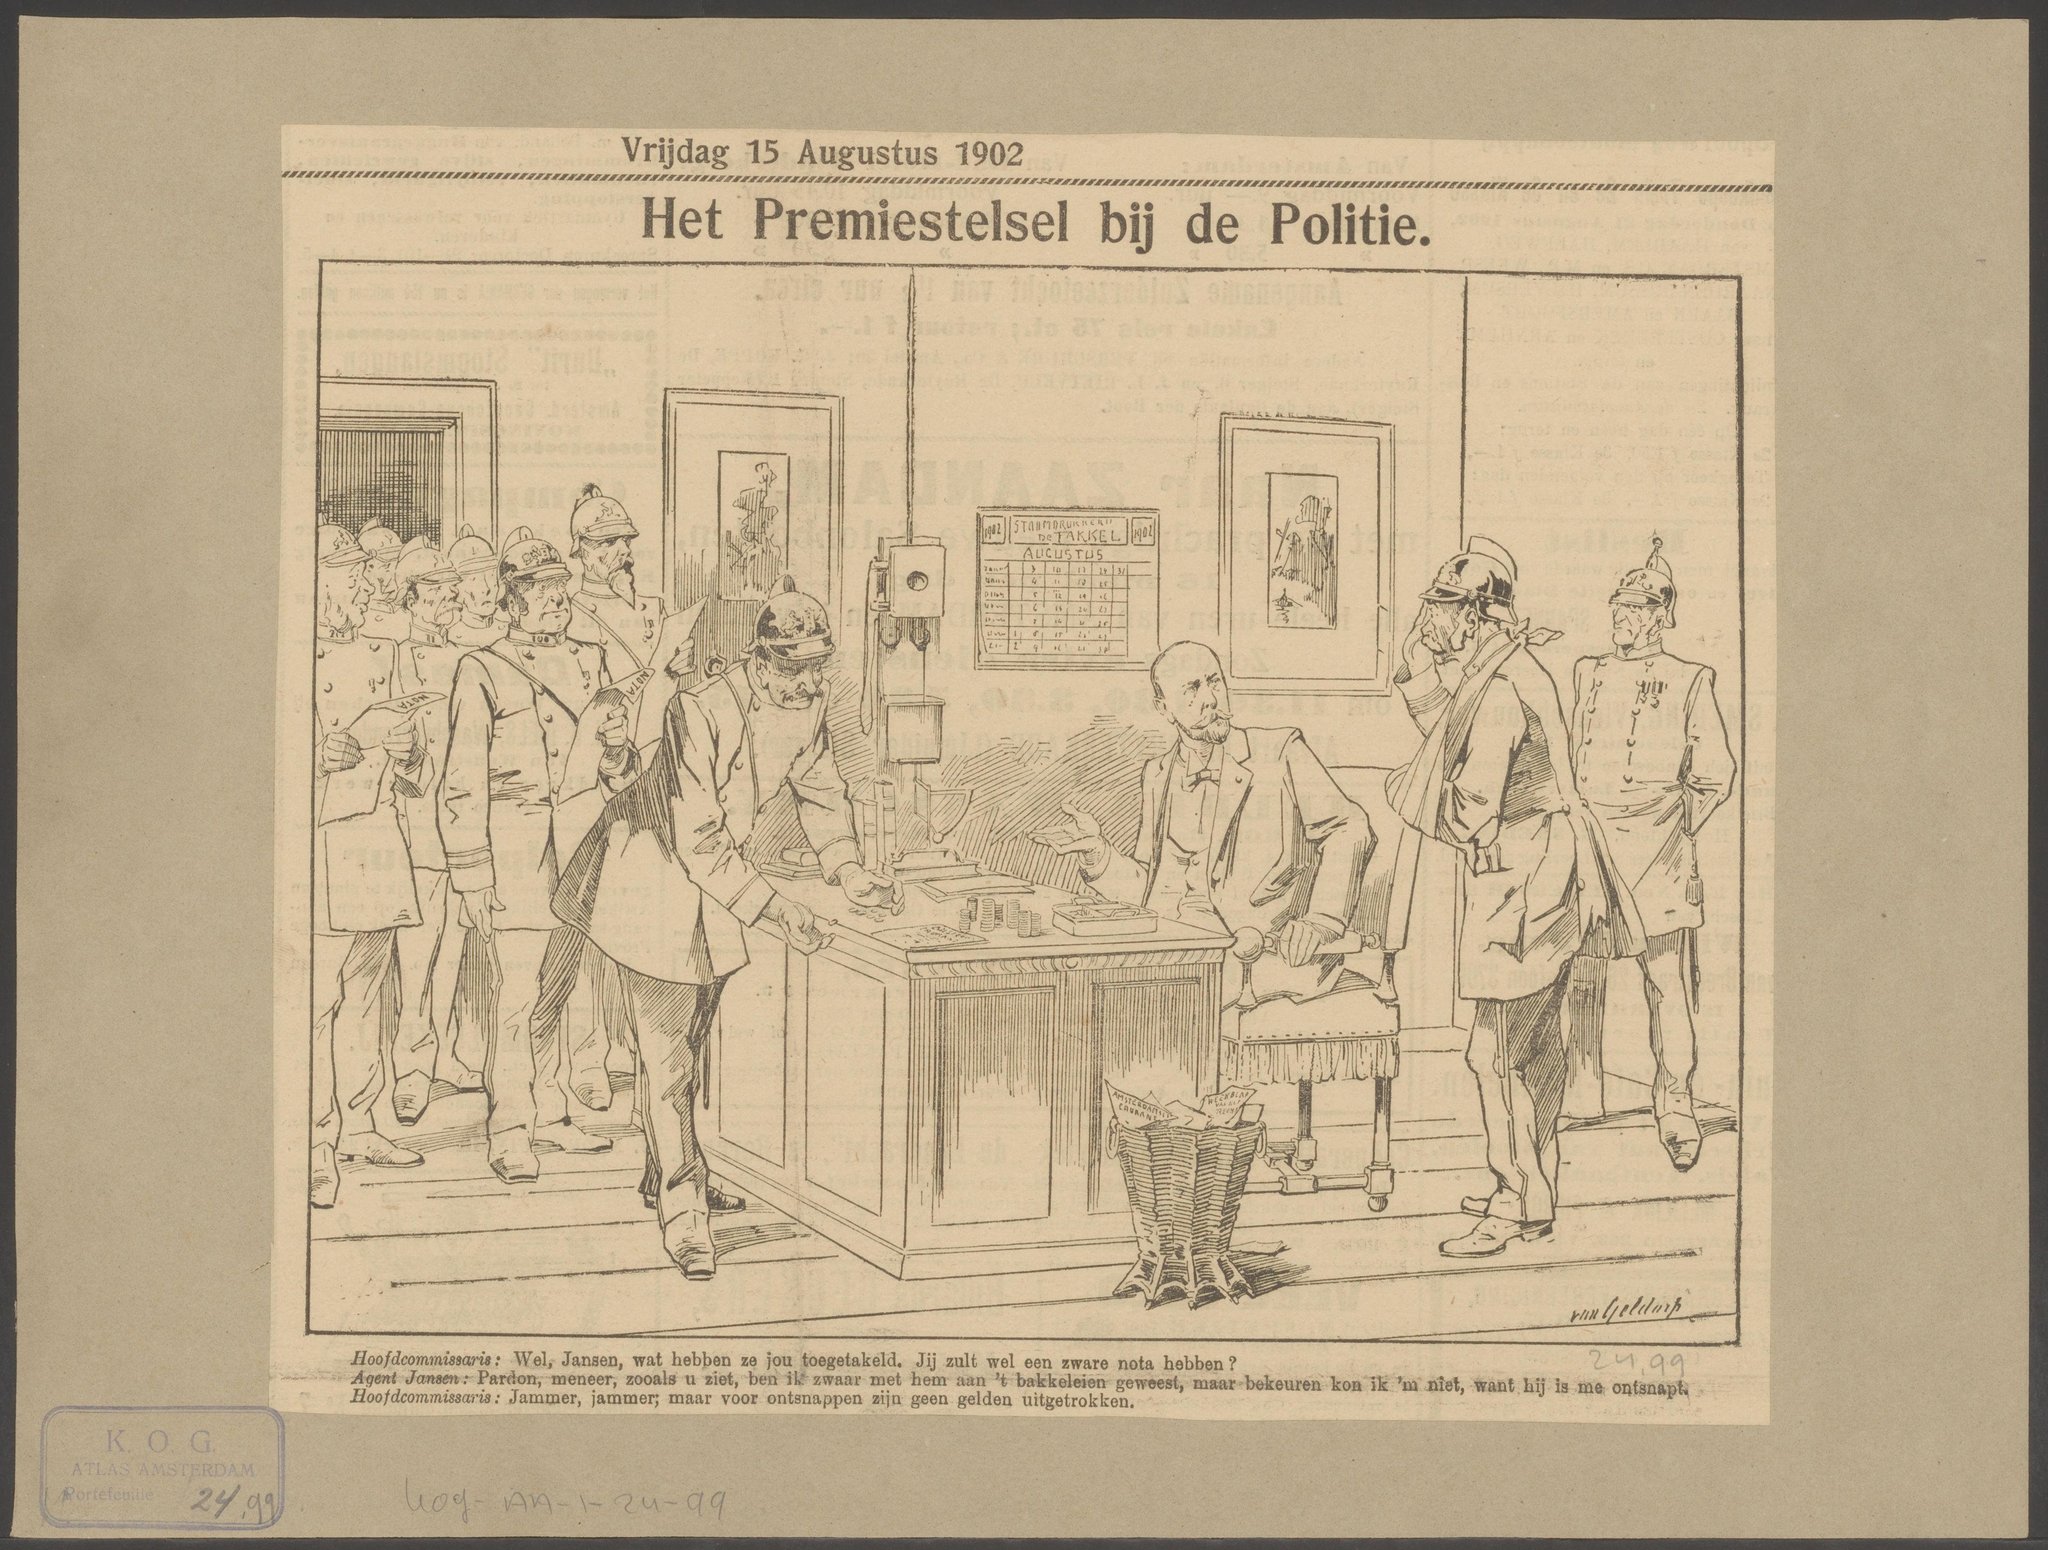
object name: photomechanical print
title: Het Premiestelsel bij de Politie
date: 1902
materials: paper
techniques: letterpress printing, line block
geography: netherlands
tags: delft, writing-table, writing-desk, policeman, constable, amsterdam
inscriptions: collector's mark: Lugt 1641b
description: Prent mogelijk uit: De Amsterdamsche Courant, 15 augustus 1902.